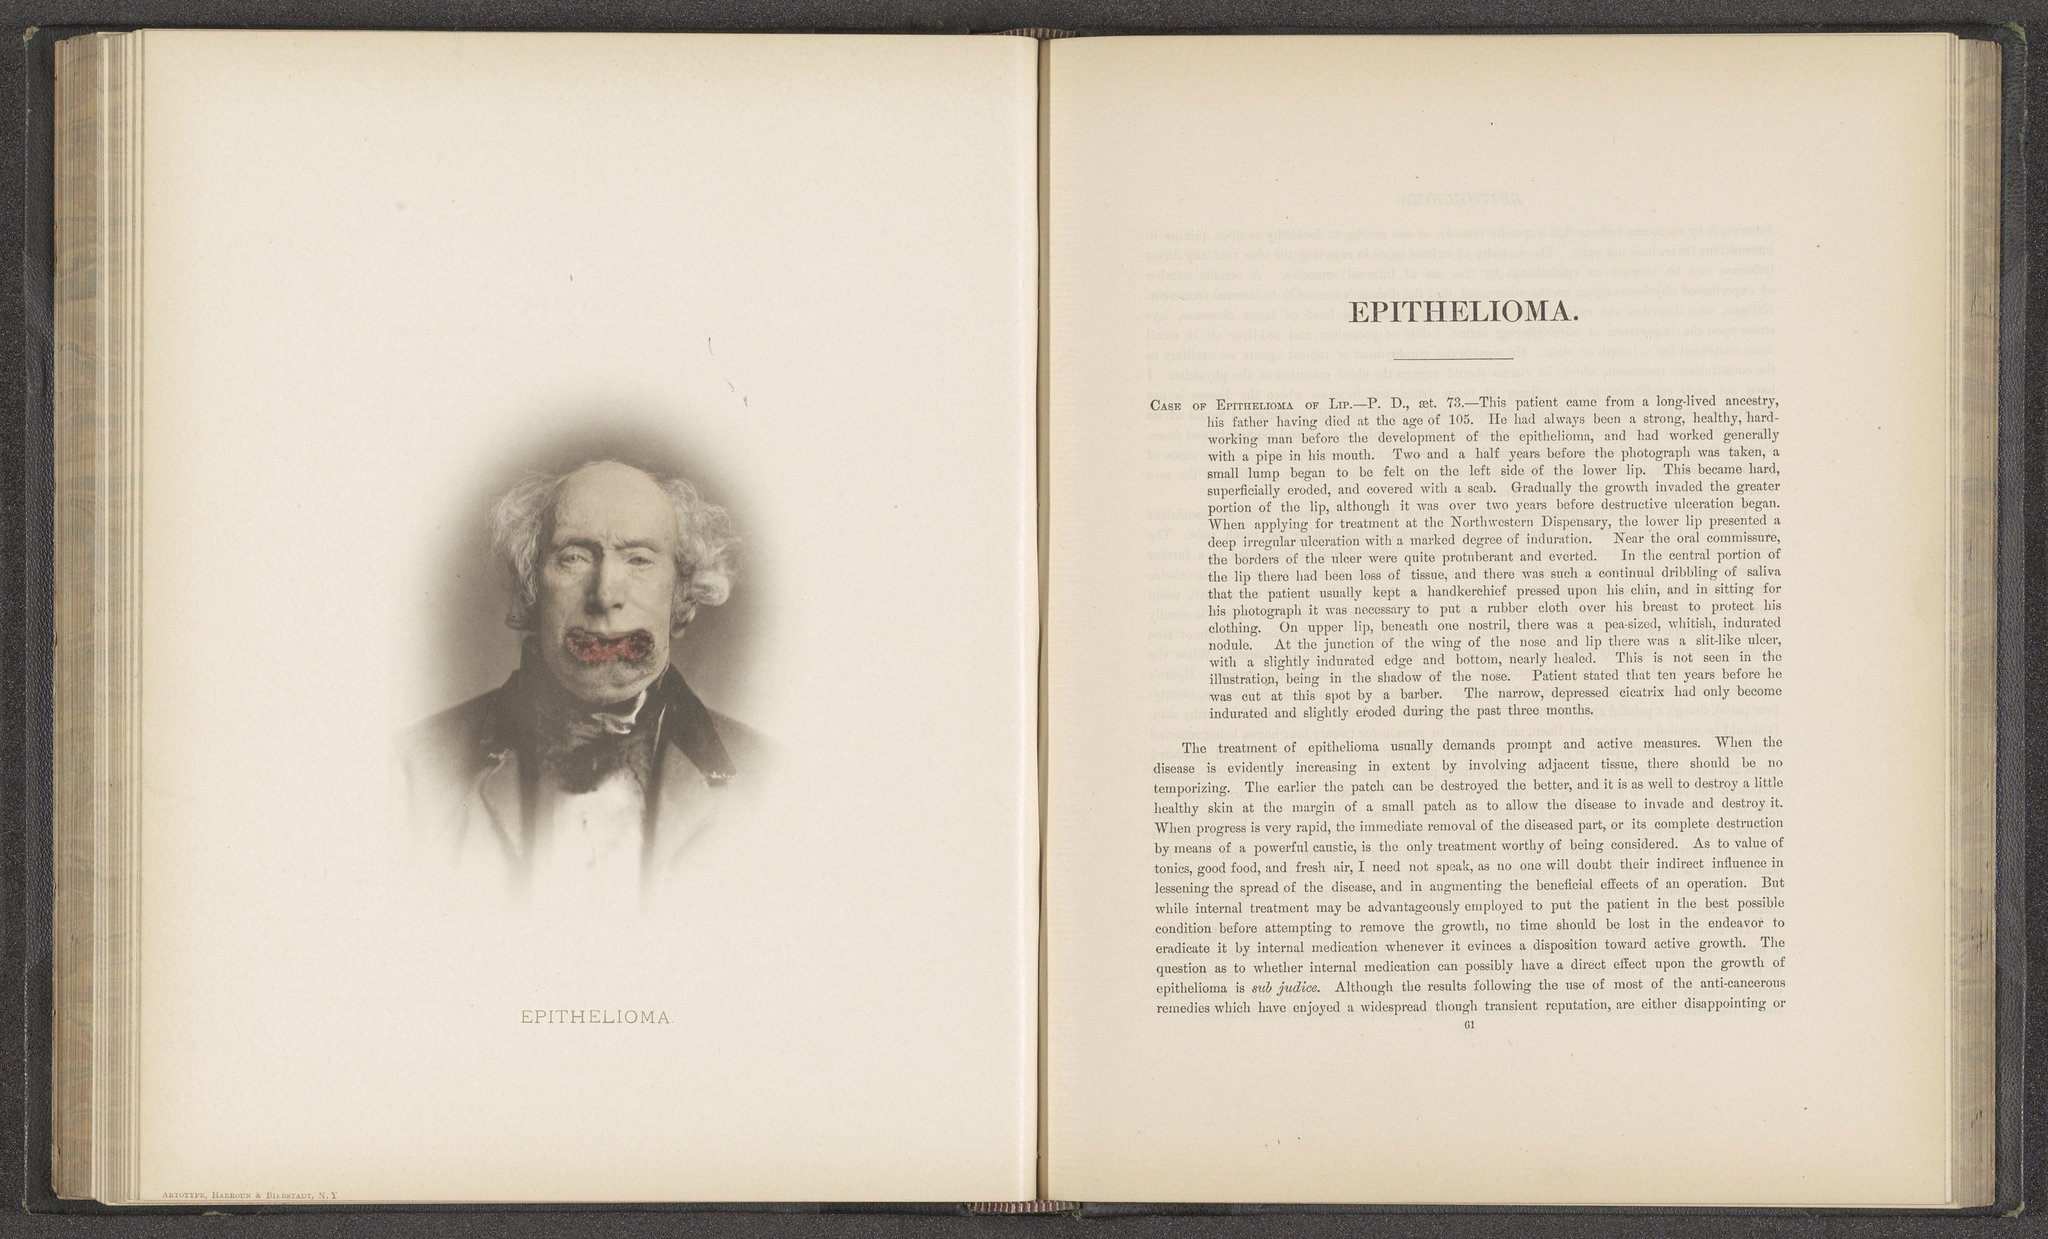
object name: page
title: Epithelioma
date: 1870-1881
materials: paper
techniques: photograph, hand coloring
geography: new york city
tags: face, skin and venereal diseases, adult man